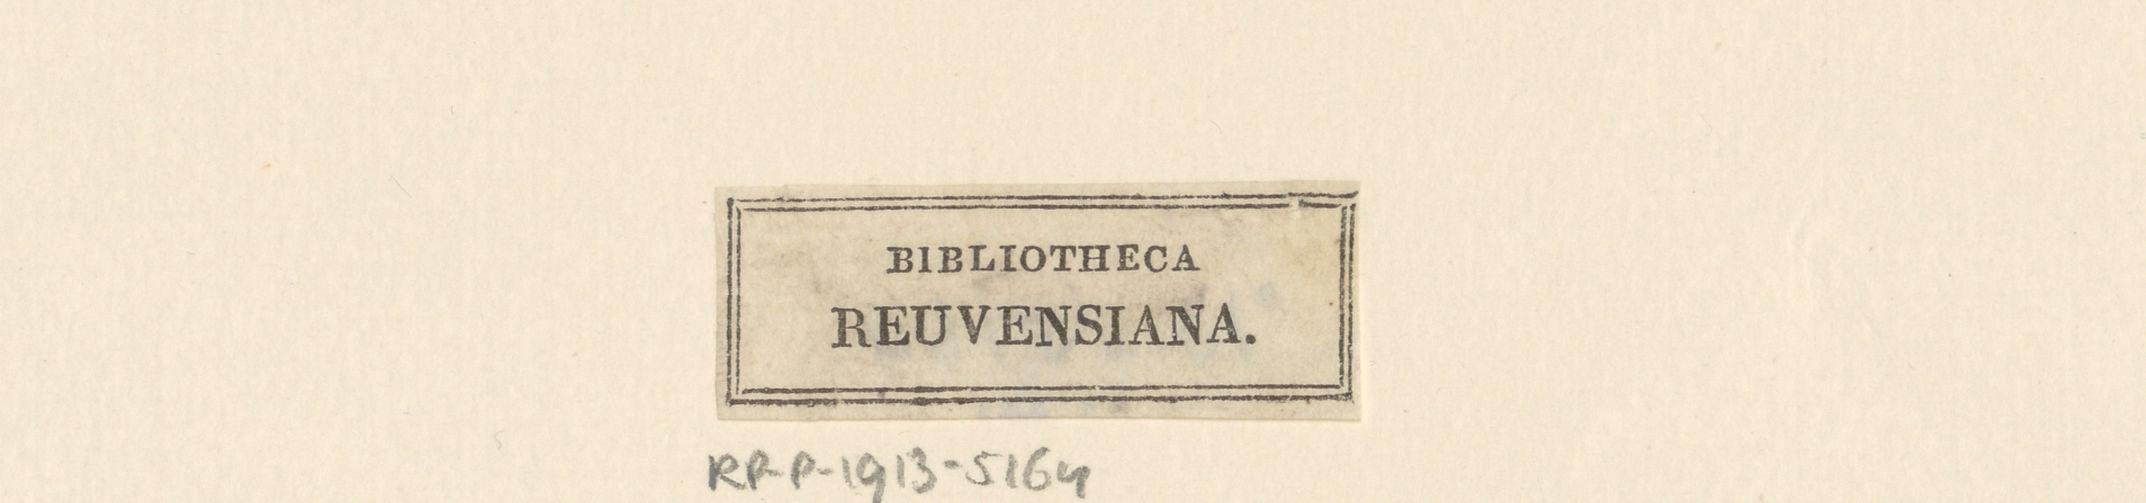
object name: bookplate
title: Ex libris van Caspar Jacob Christiaan Reuvens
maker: Anonymous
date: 1803-1835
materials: paper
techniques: printing block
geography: netherlands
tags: caspar jacob christiaan reuvens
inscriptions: collector's mark: Lugt 2233, collector's mark: Lugt 2760